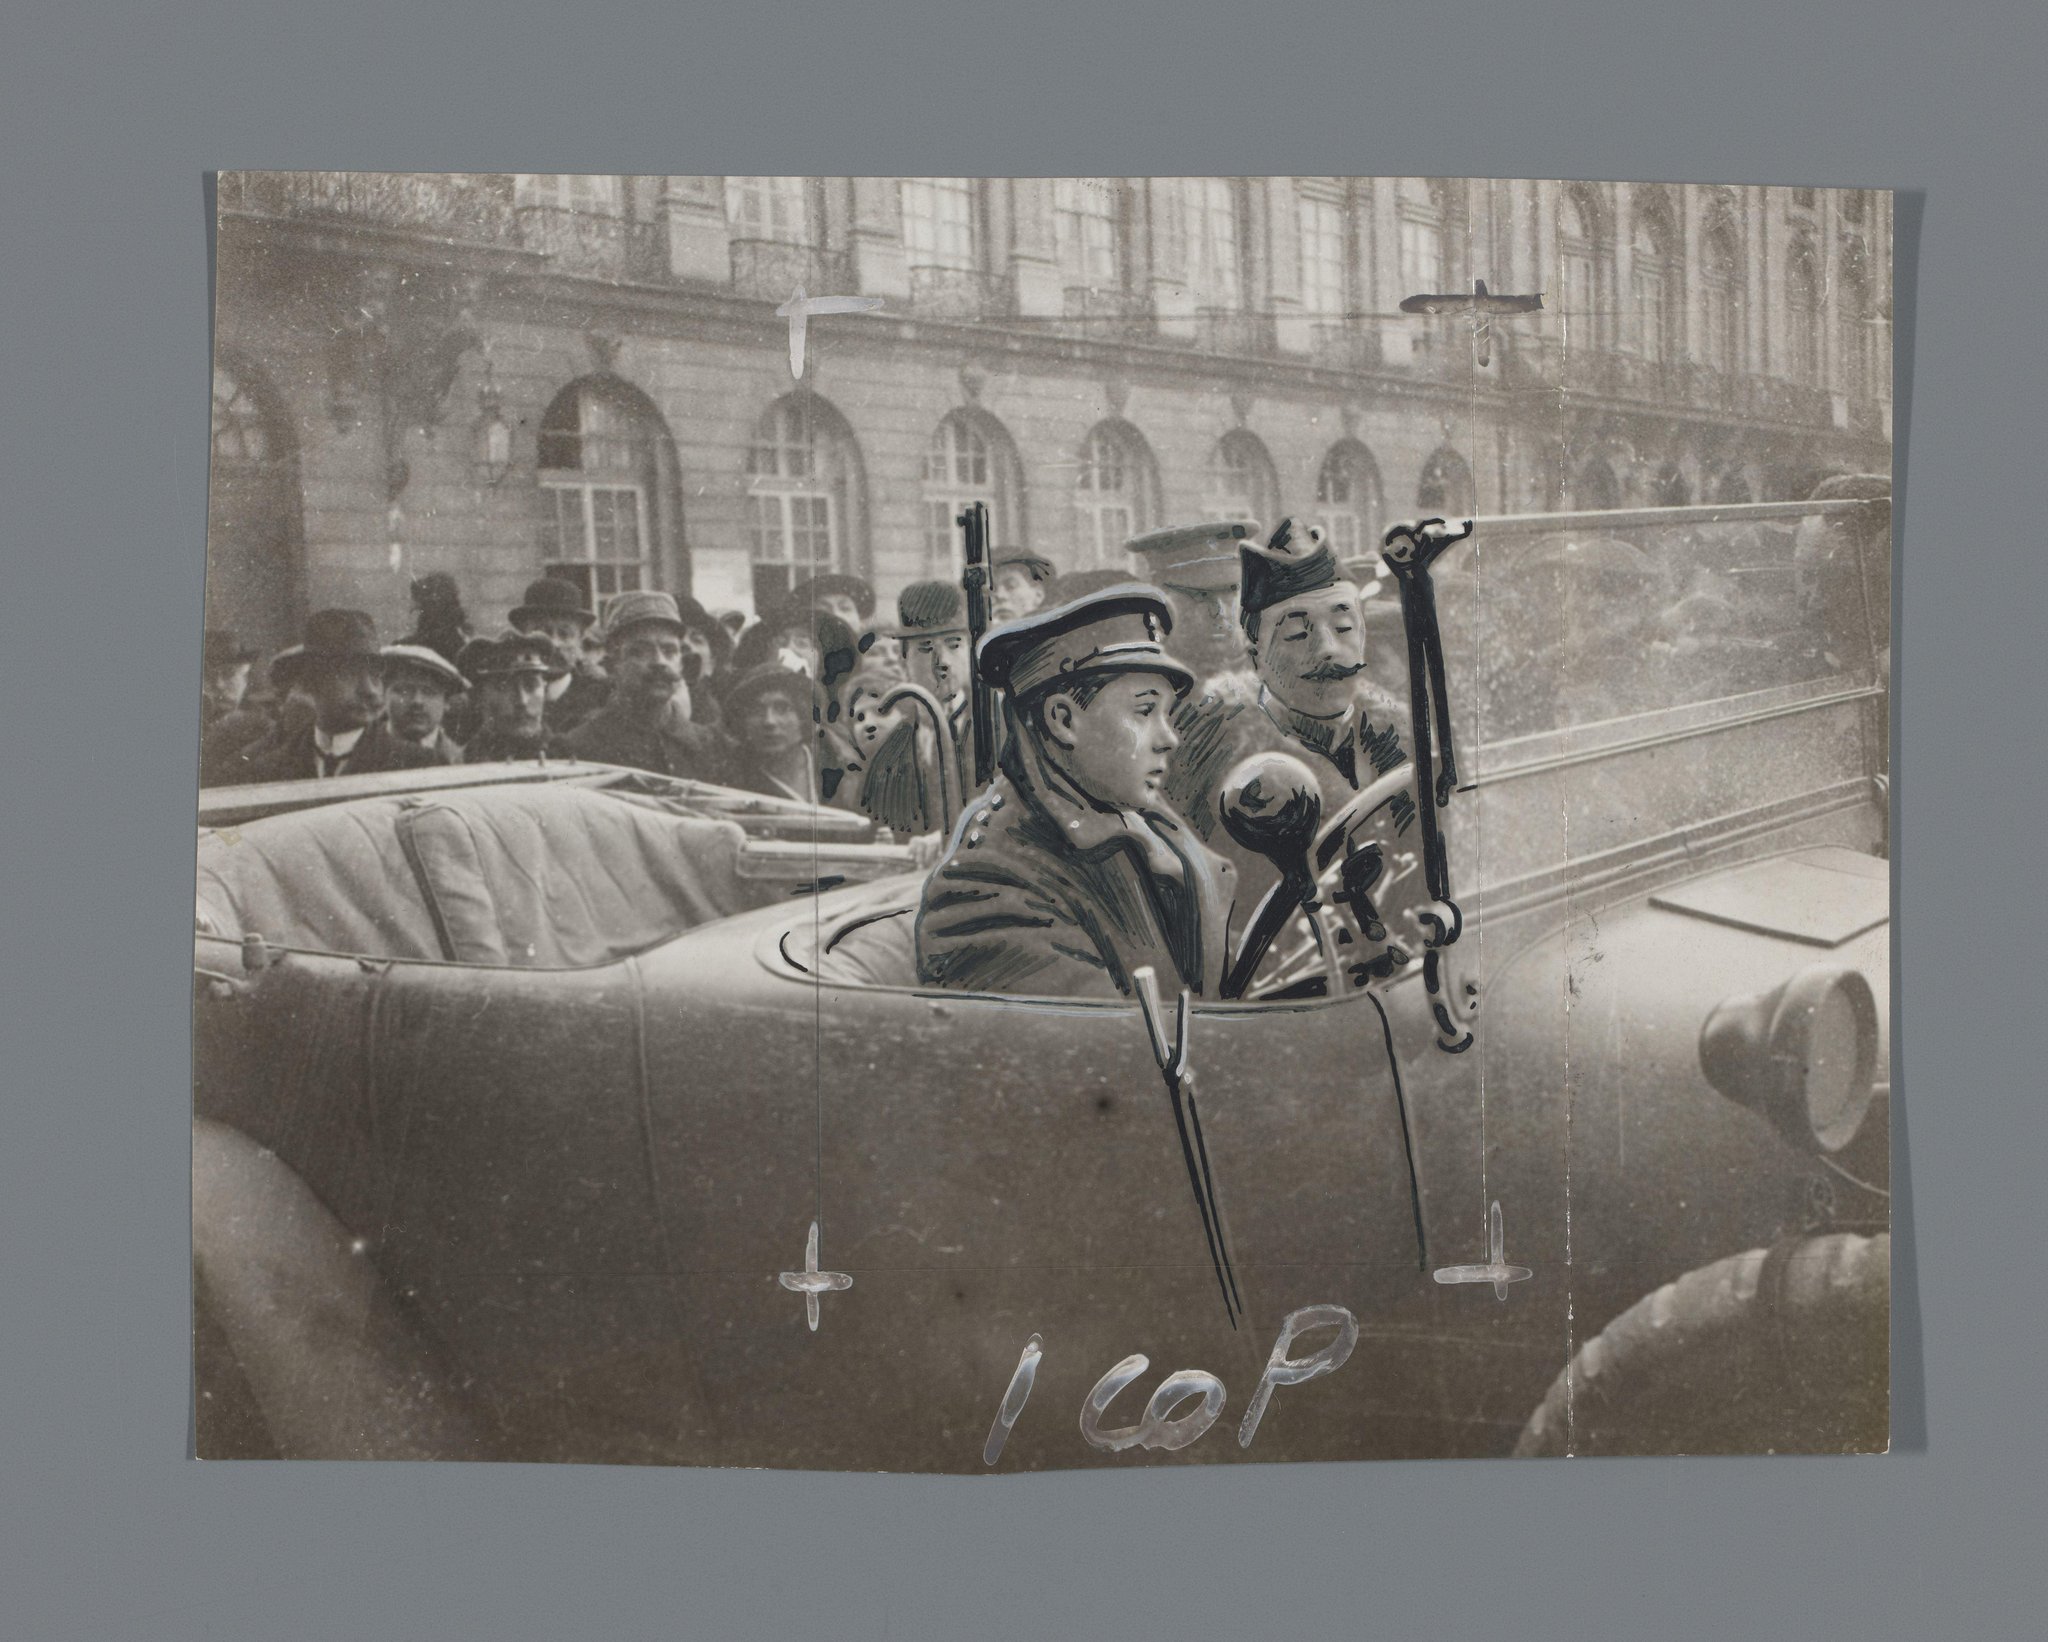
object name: photograph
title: Edward Prince of Wales (de latere koning Edward VIII) in een auto, Parijs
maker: Anonymous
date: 1915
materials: ink, photographic support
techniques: gelatin silver print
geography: paris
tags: united kingdom, paris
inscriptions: stamp: ‘SOCIETE DE PETIT PARISIEN / DUPUY & Cie / 20 JAN 1915 / 18 Rue d’Enghien. PARIS’